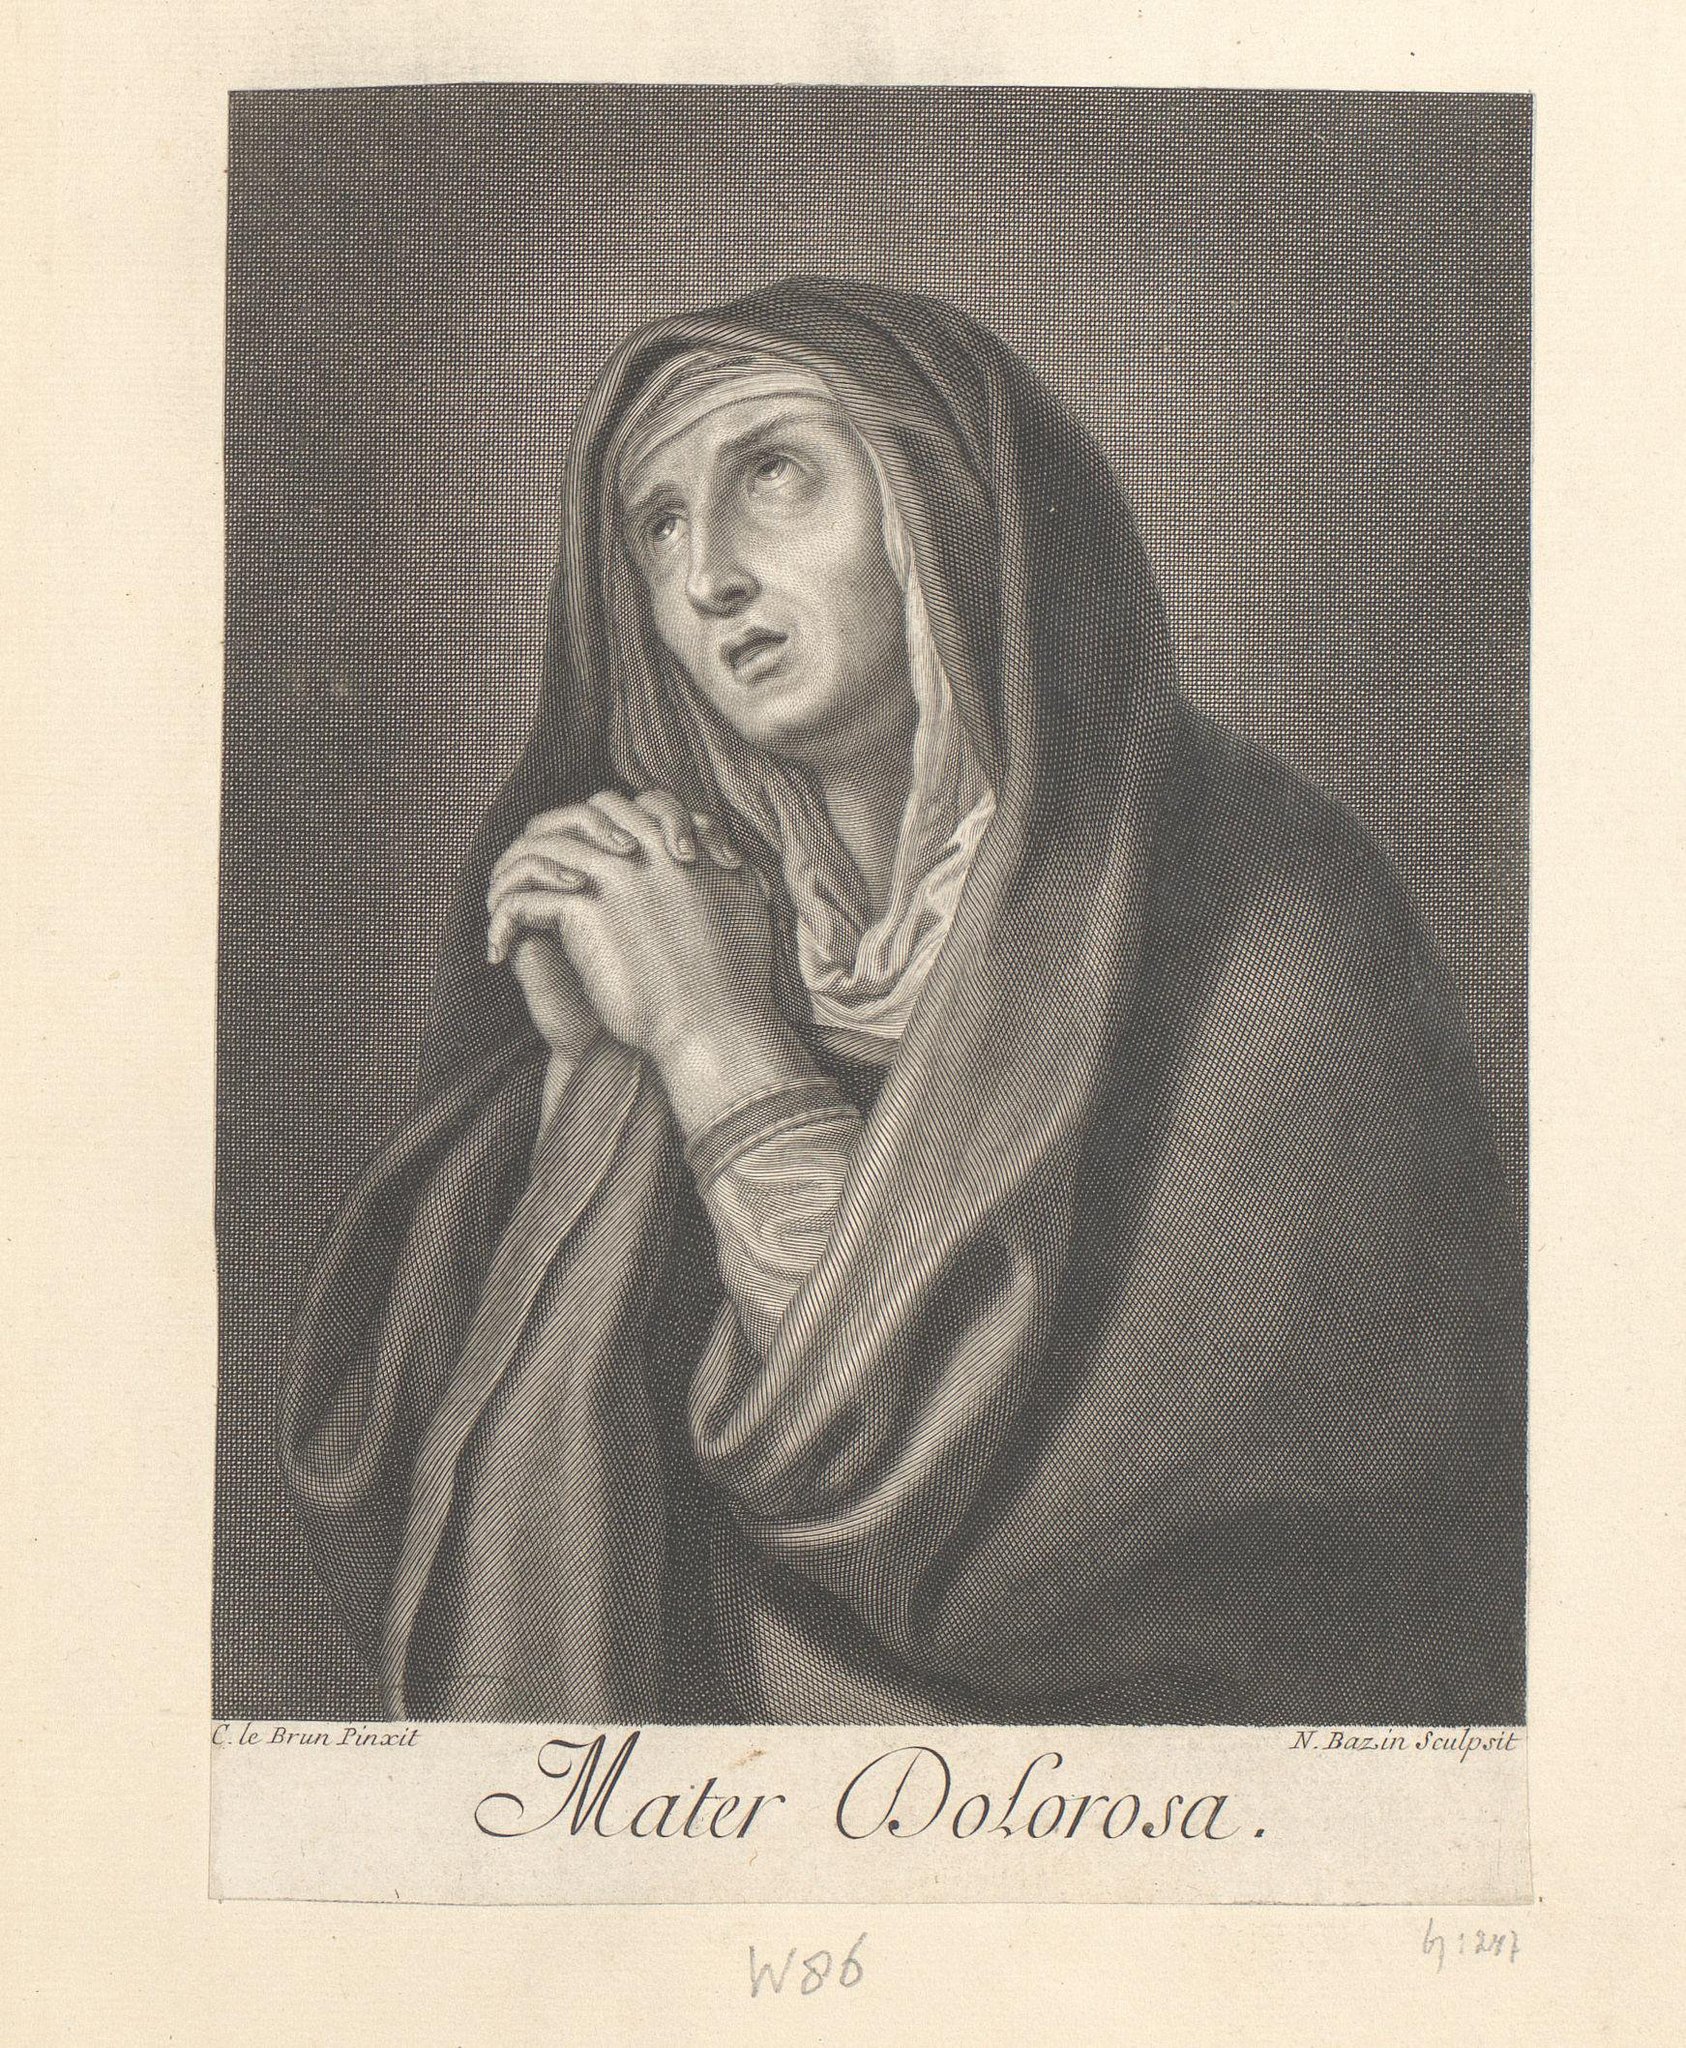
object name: print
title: Werken van Charles le Brun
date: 1643-1710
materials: paper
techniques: engraving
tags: 'mater dolorosa' - ff - 'mater dolorosa', head or bust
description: Deze prent maakt deel uit van een album.